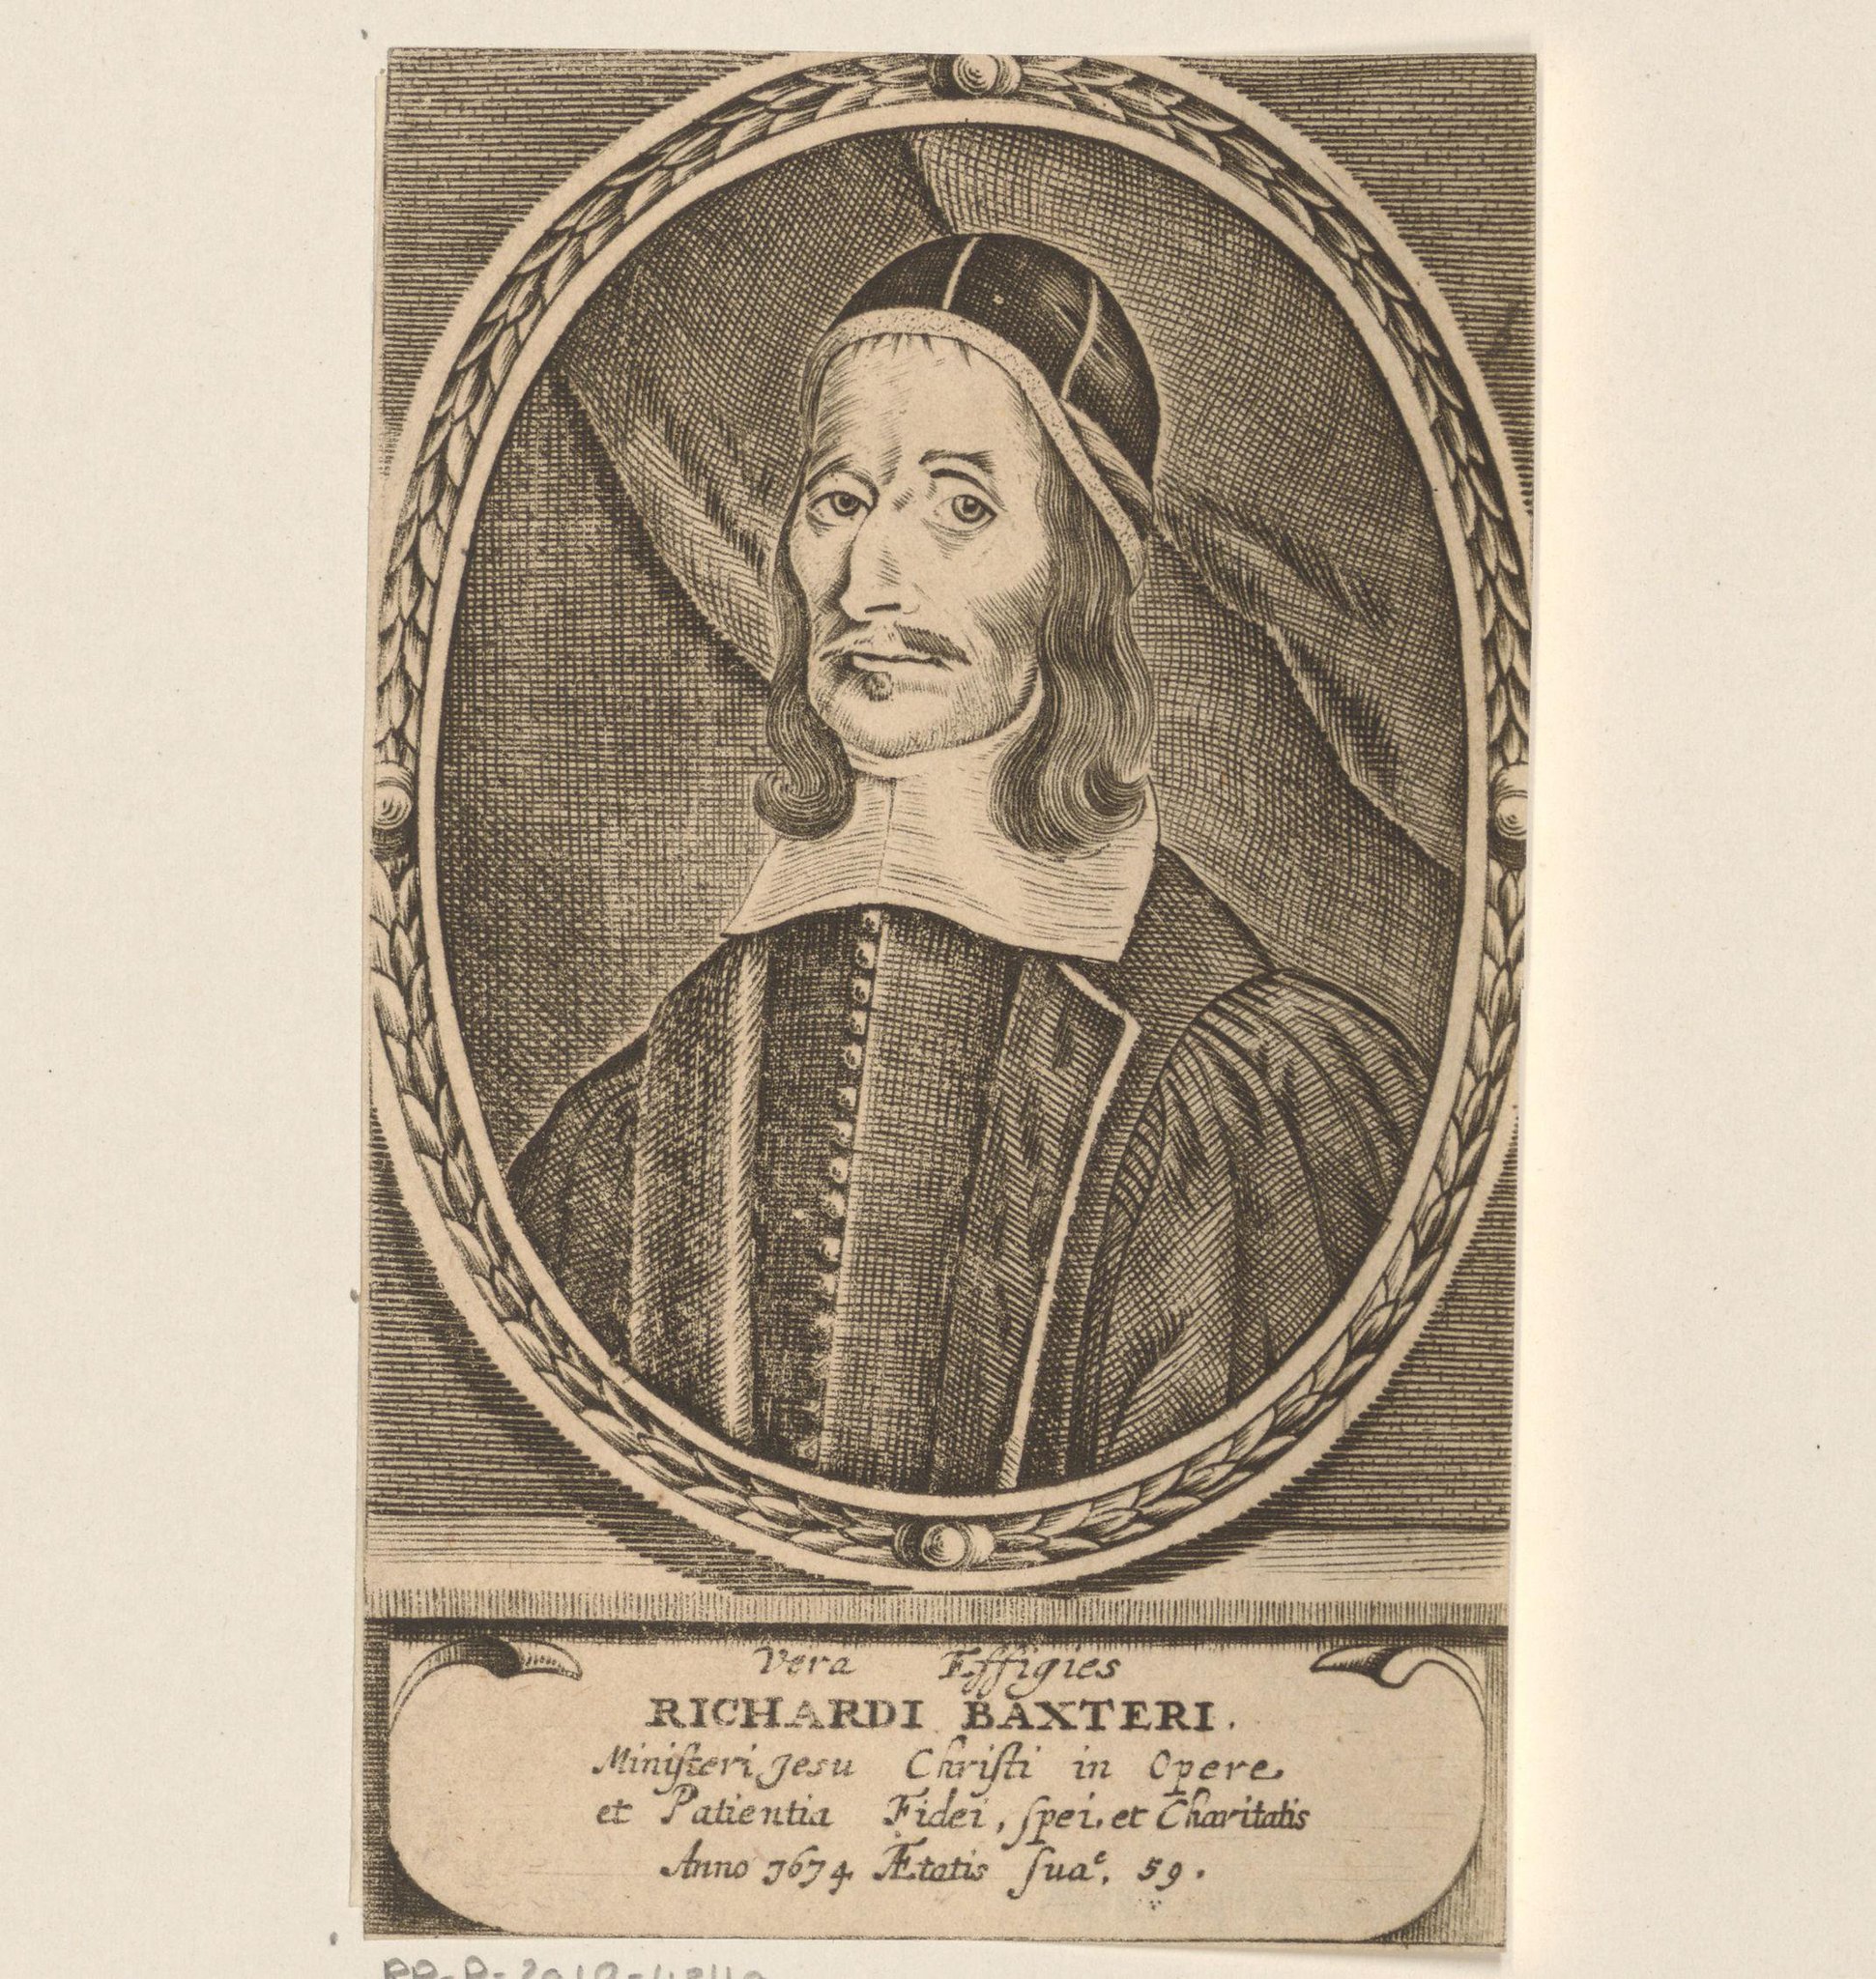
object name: print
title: Portret van Richard Baxter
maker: Anonymous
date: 1674-1749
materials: paper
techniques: engraving, etching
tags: london, historical persons